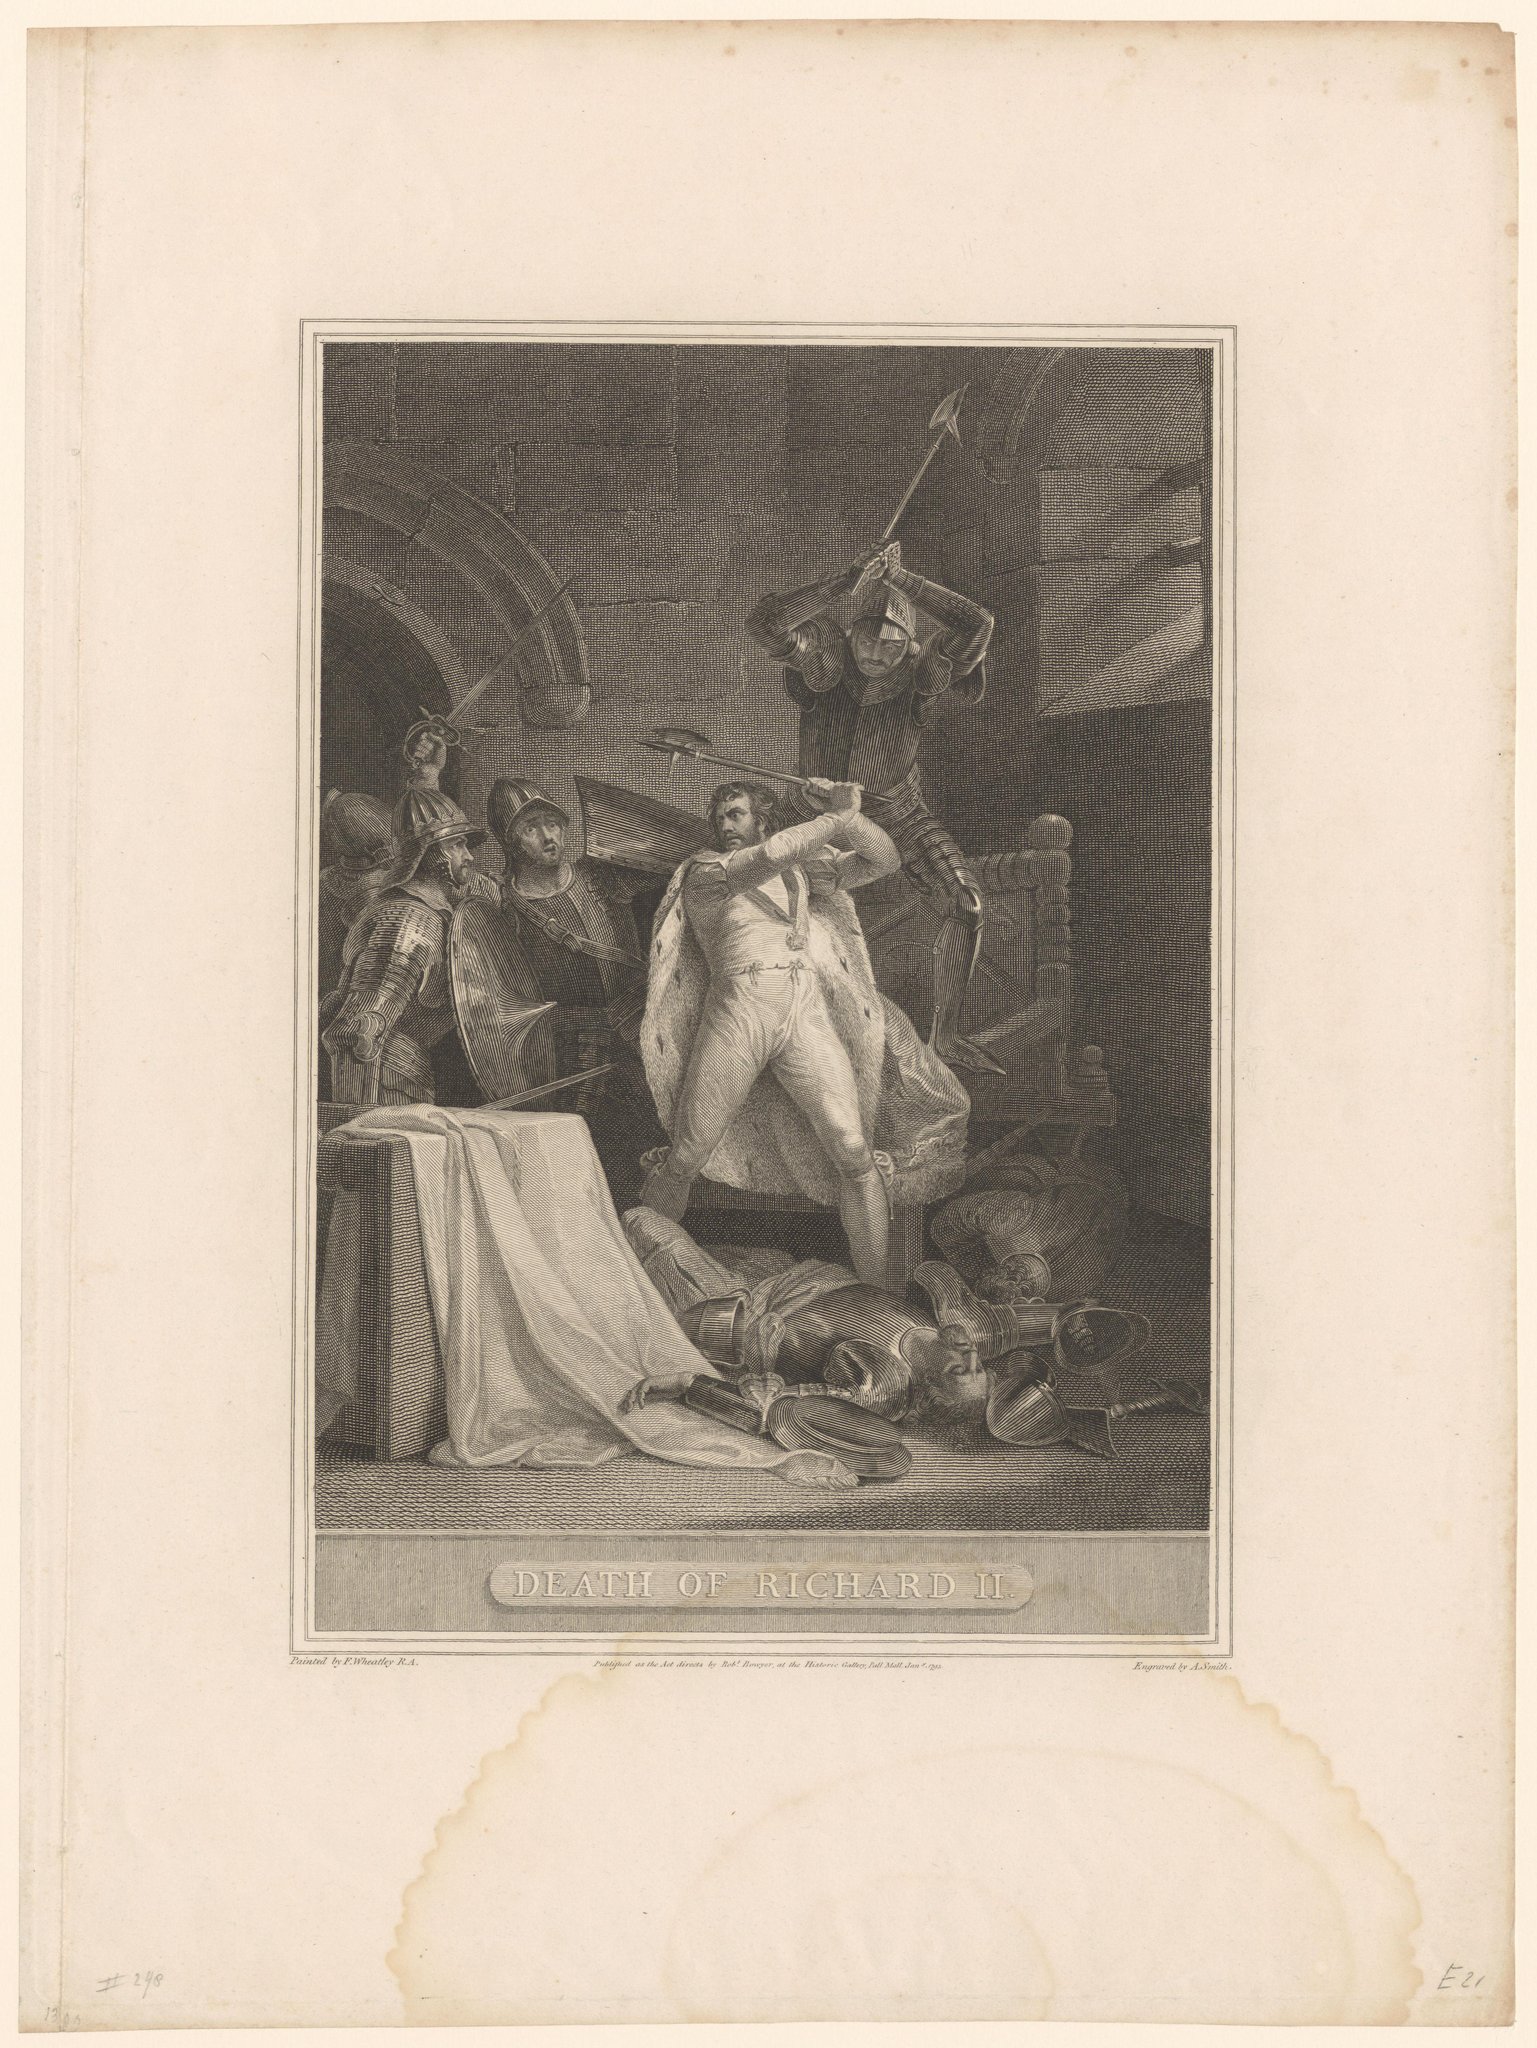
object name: print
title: The Historic Gallery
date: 1701-1795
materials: paper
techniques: etching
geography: great britain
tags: regicide, armour, being attacked; defence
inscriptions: collector's mark: Lugt 2228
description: De prenten uit deze serie zijn naar schilderijen uit Bowyer's Historic Gallery. Deze schilderijen en tekeningen illustreerden de gebeurtenissen uit David Hume's History of England. De prenten zijn daarom mogelijk gebruikt als illustratie in deze boeken.